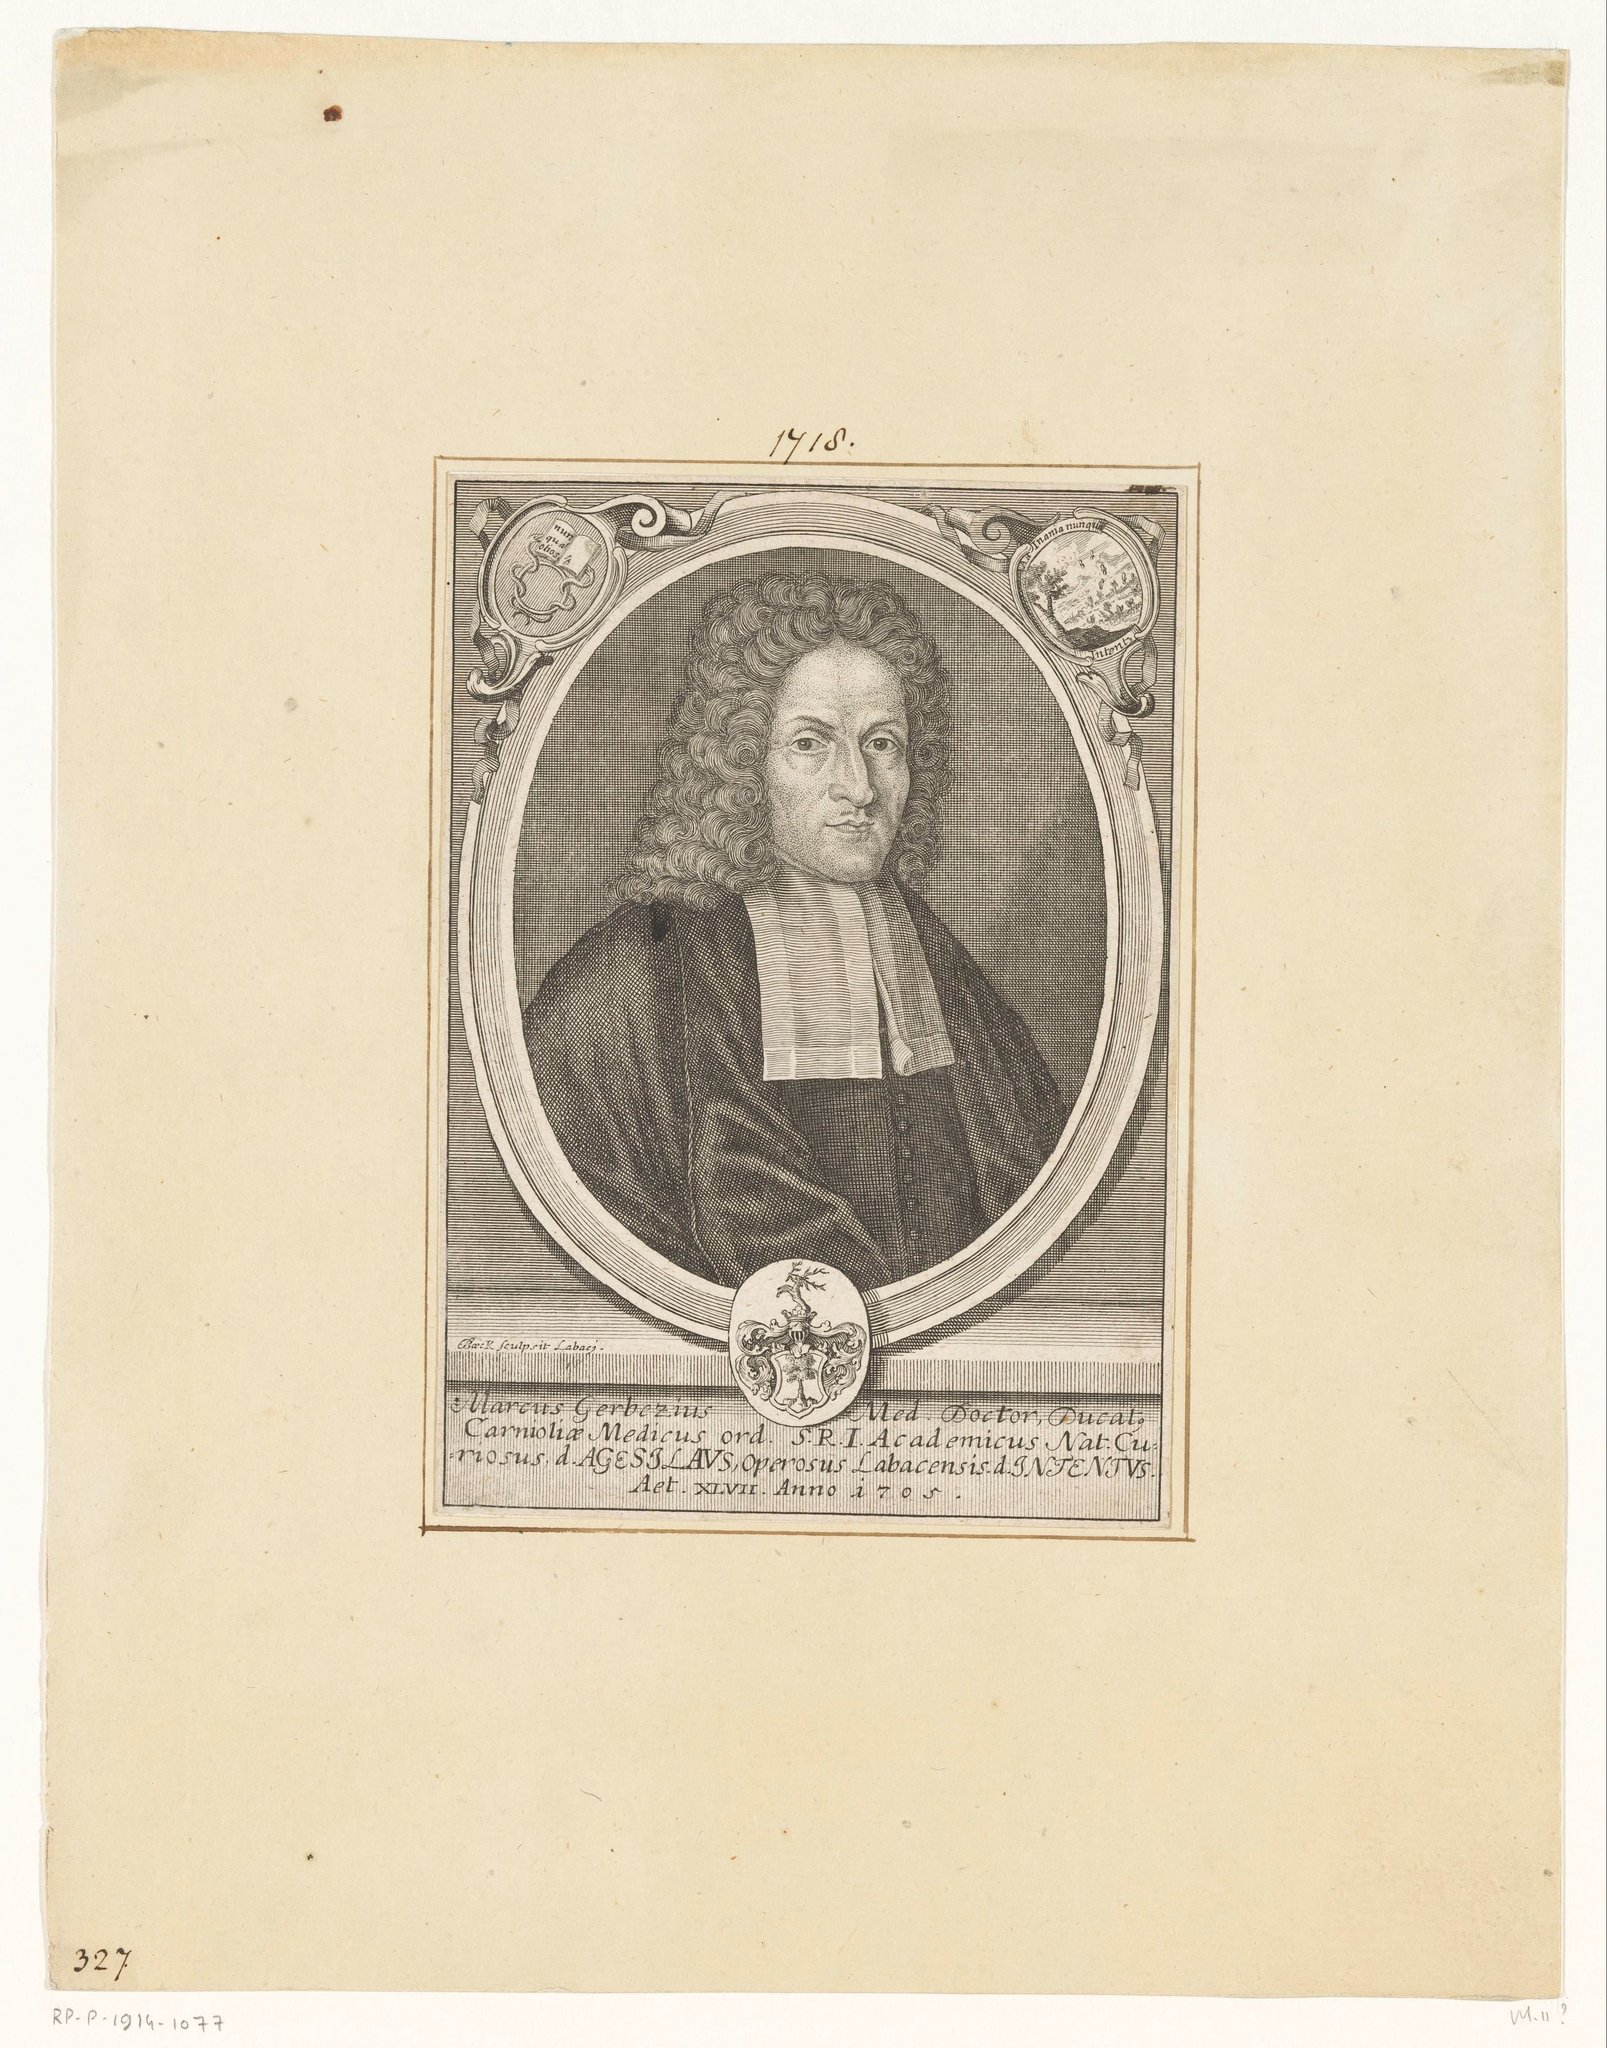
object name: print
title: Portret van Marcus Gerbezius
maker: elias baeck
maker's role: print maker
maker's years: 1679-1747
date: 1705-1747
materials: paper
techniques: etching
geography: ljubljana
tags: historical persons, armorial bearing, heraldry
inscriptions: collector's mark: Lugt 2228